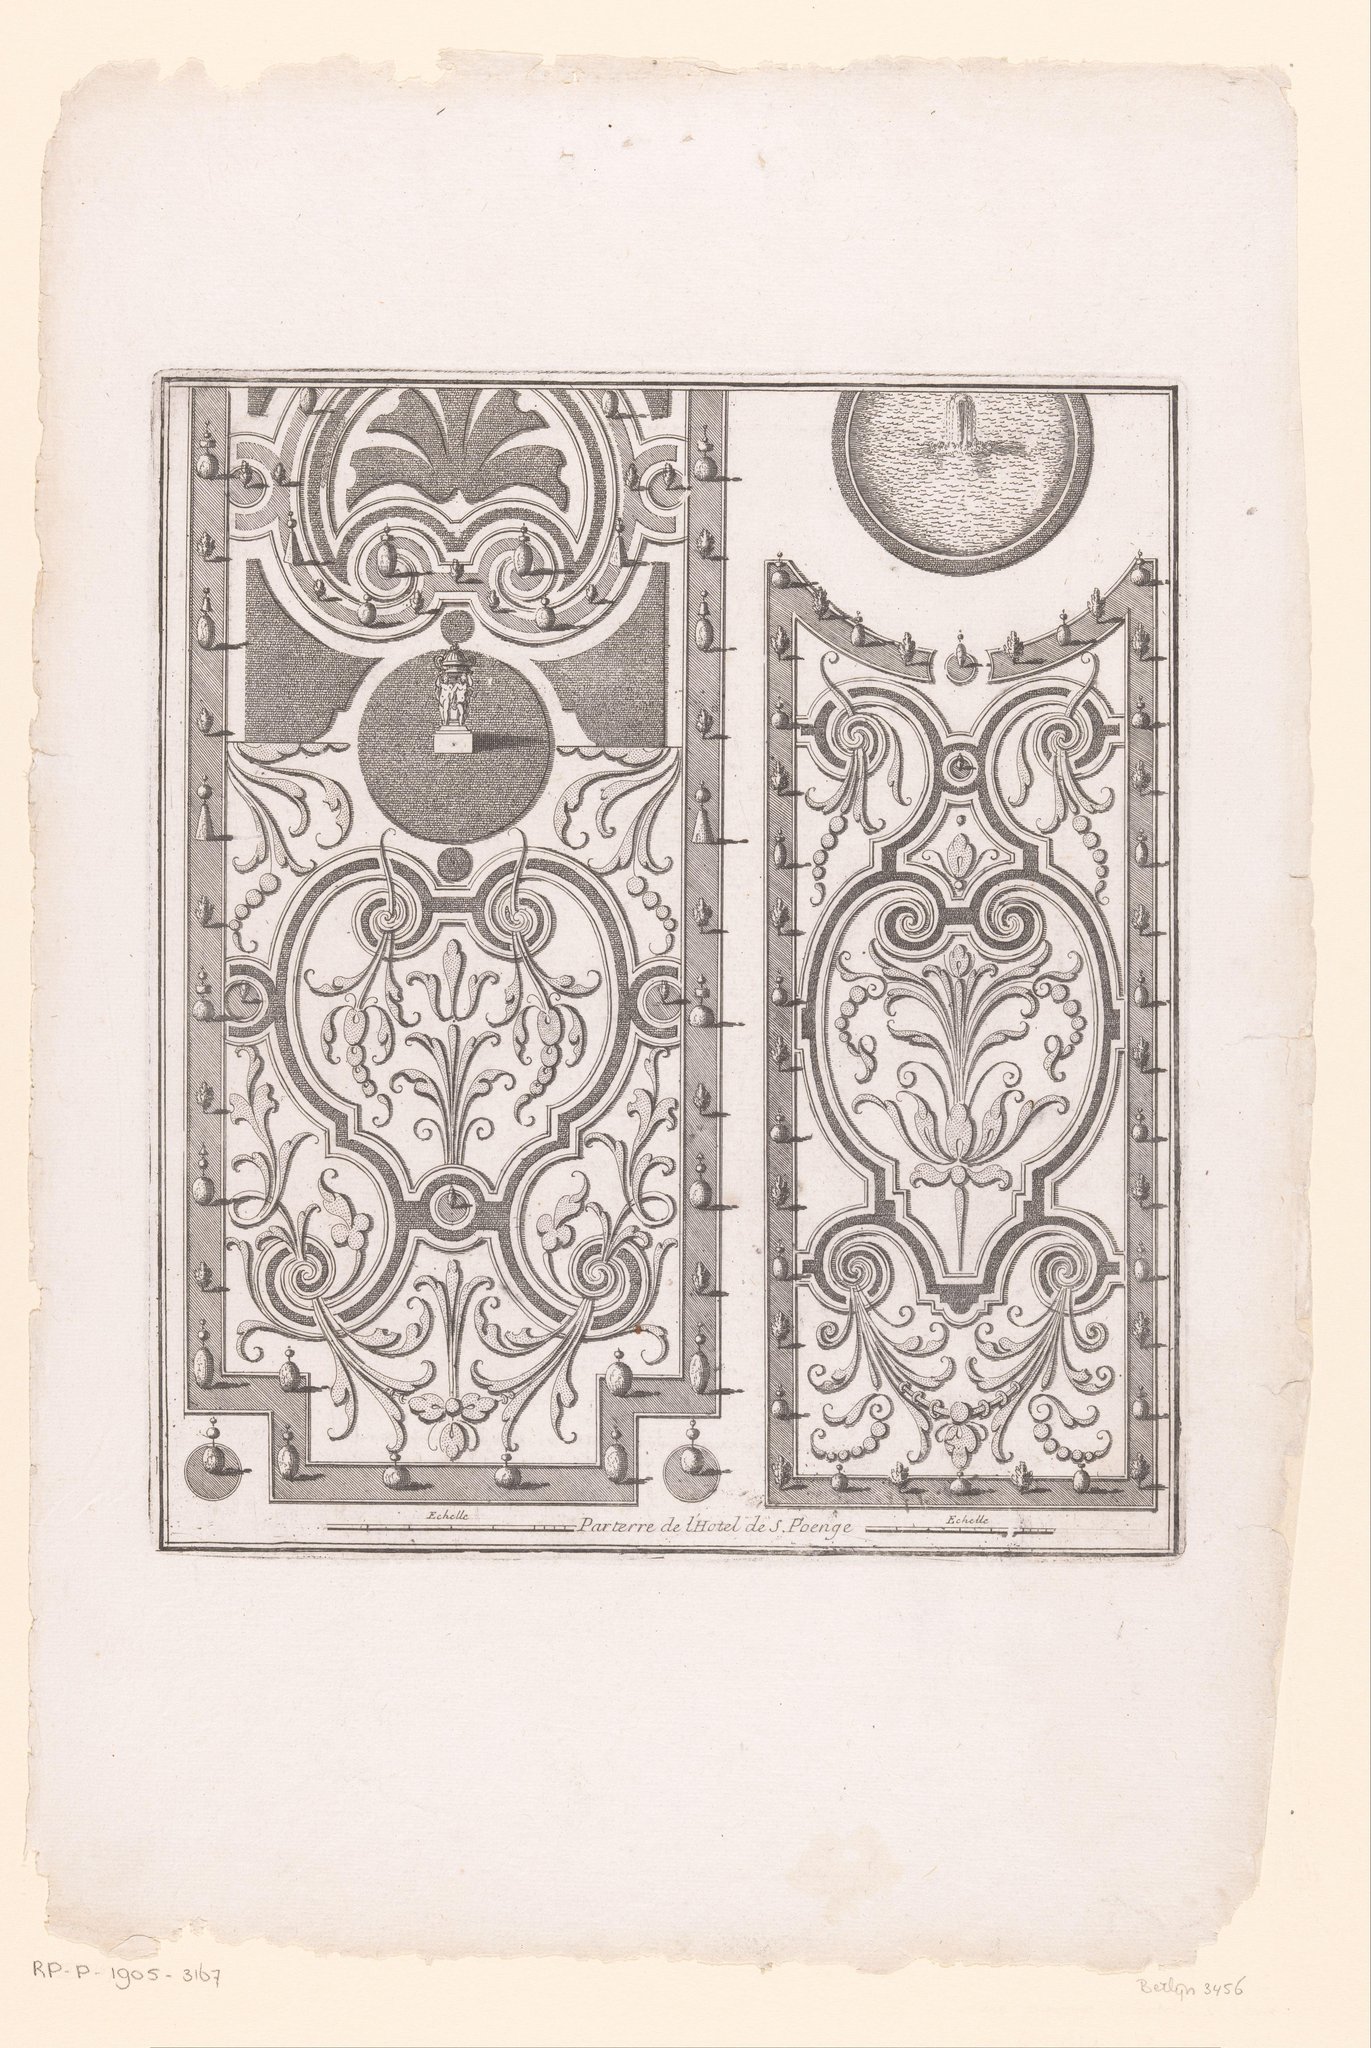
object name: print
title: Plattegrond van tuin met parterres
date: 1650-1700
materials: paper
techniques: etching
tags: plan, map of garden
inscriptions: collector's mark: Lugt 2228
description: Twee parterres. Links met aan de bovenzijde een schelpmotief en in het midden een sculptuur. Rechts met aan de bovenzijde een ronde fontein.